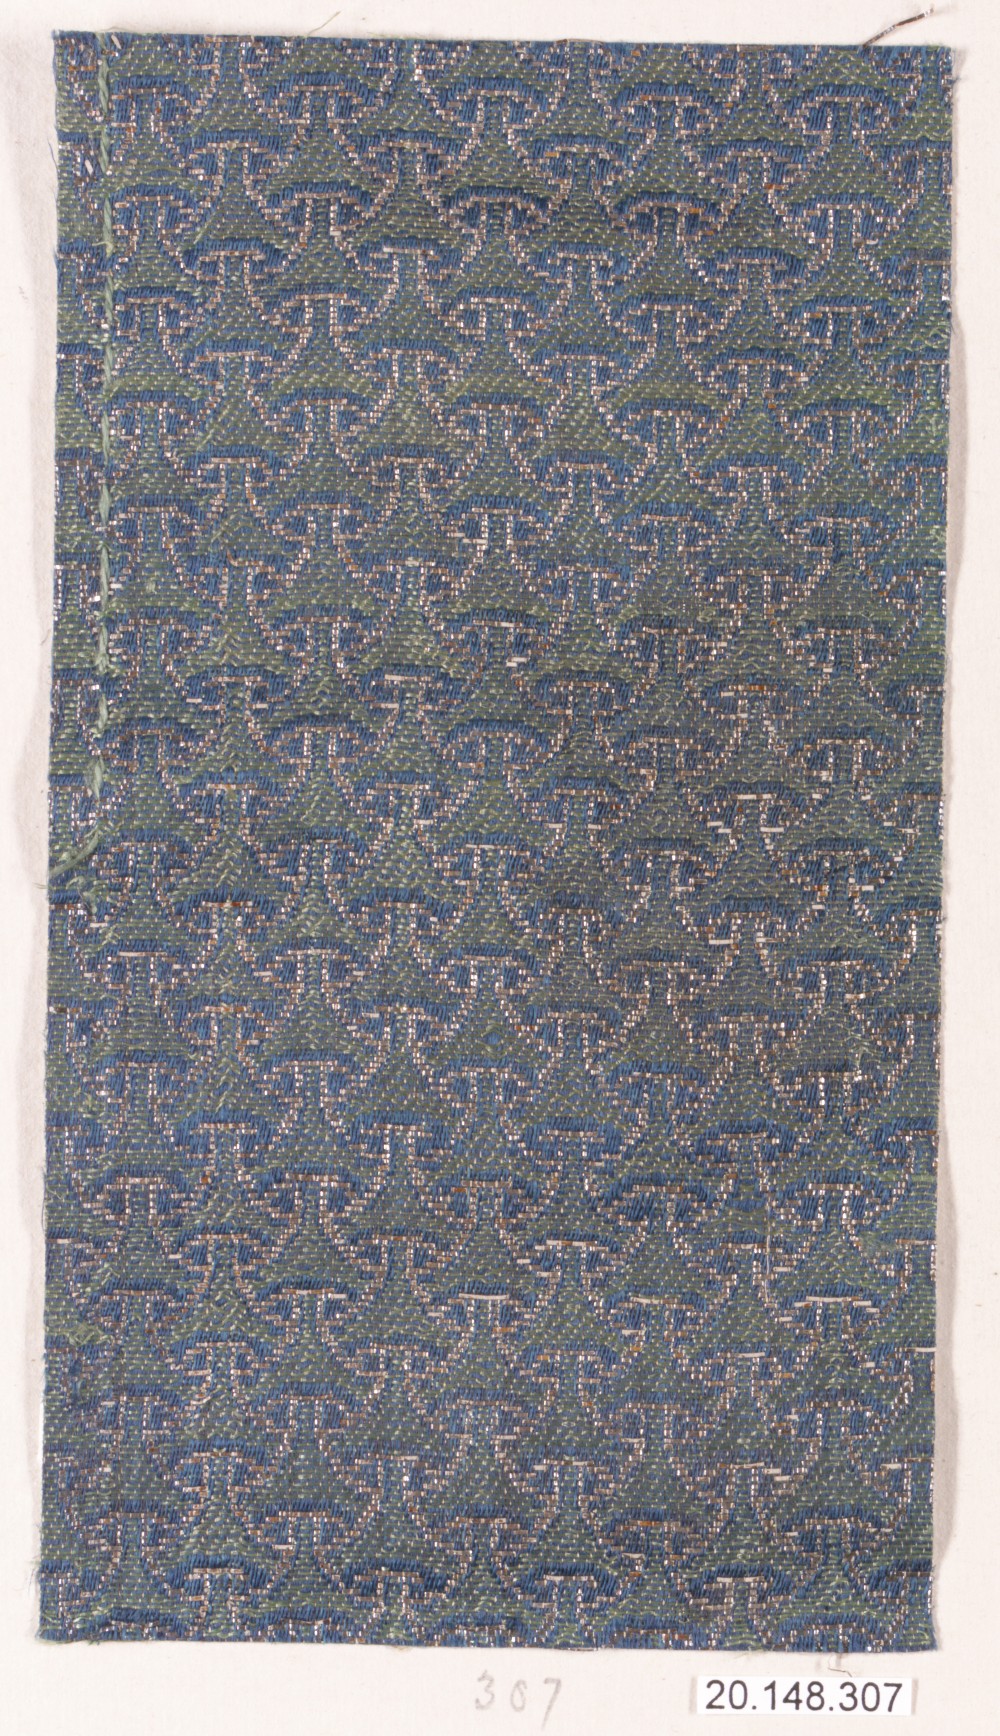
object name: piece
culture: china or japan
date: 1701-1800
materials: silk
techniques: compound weave